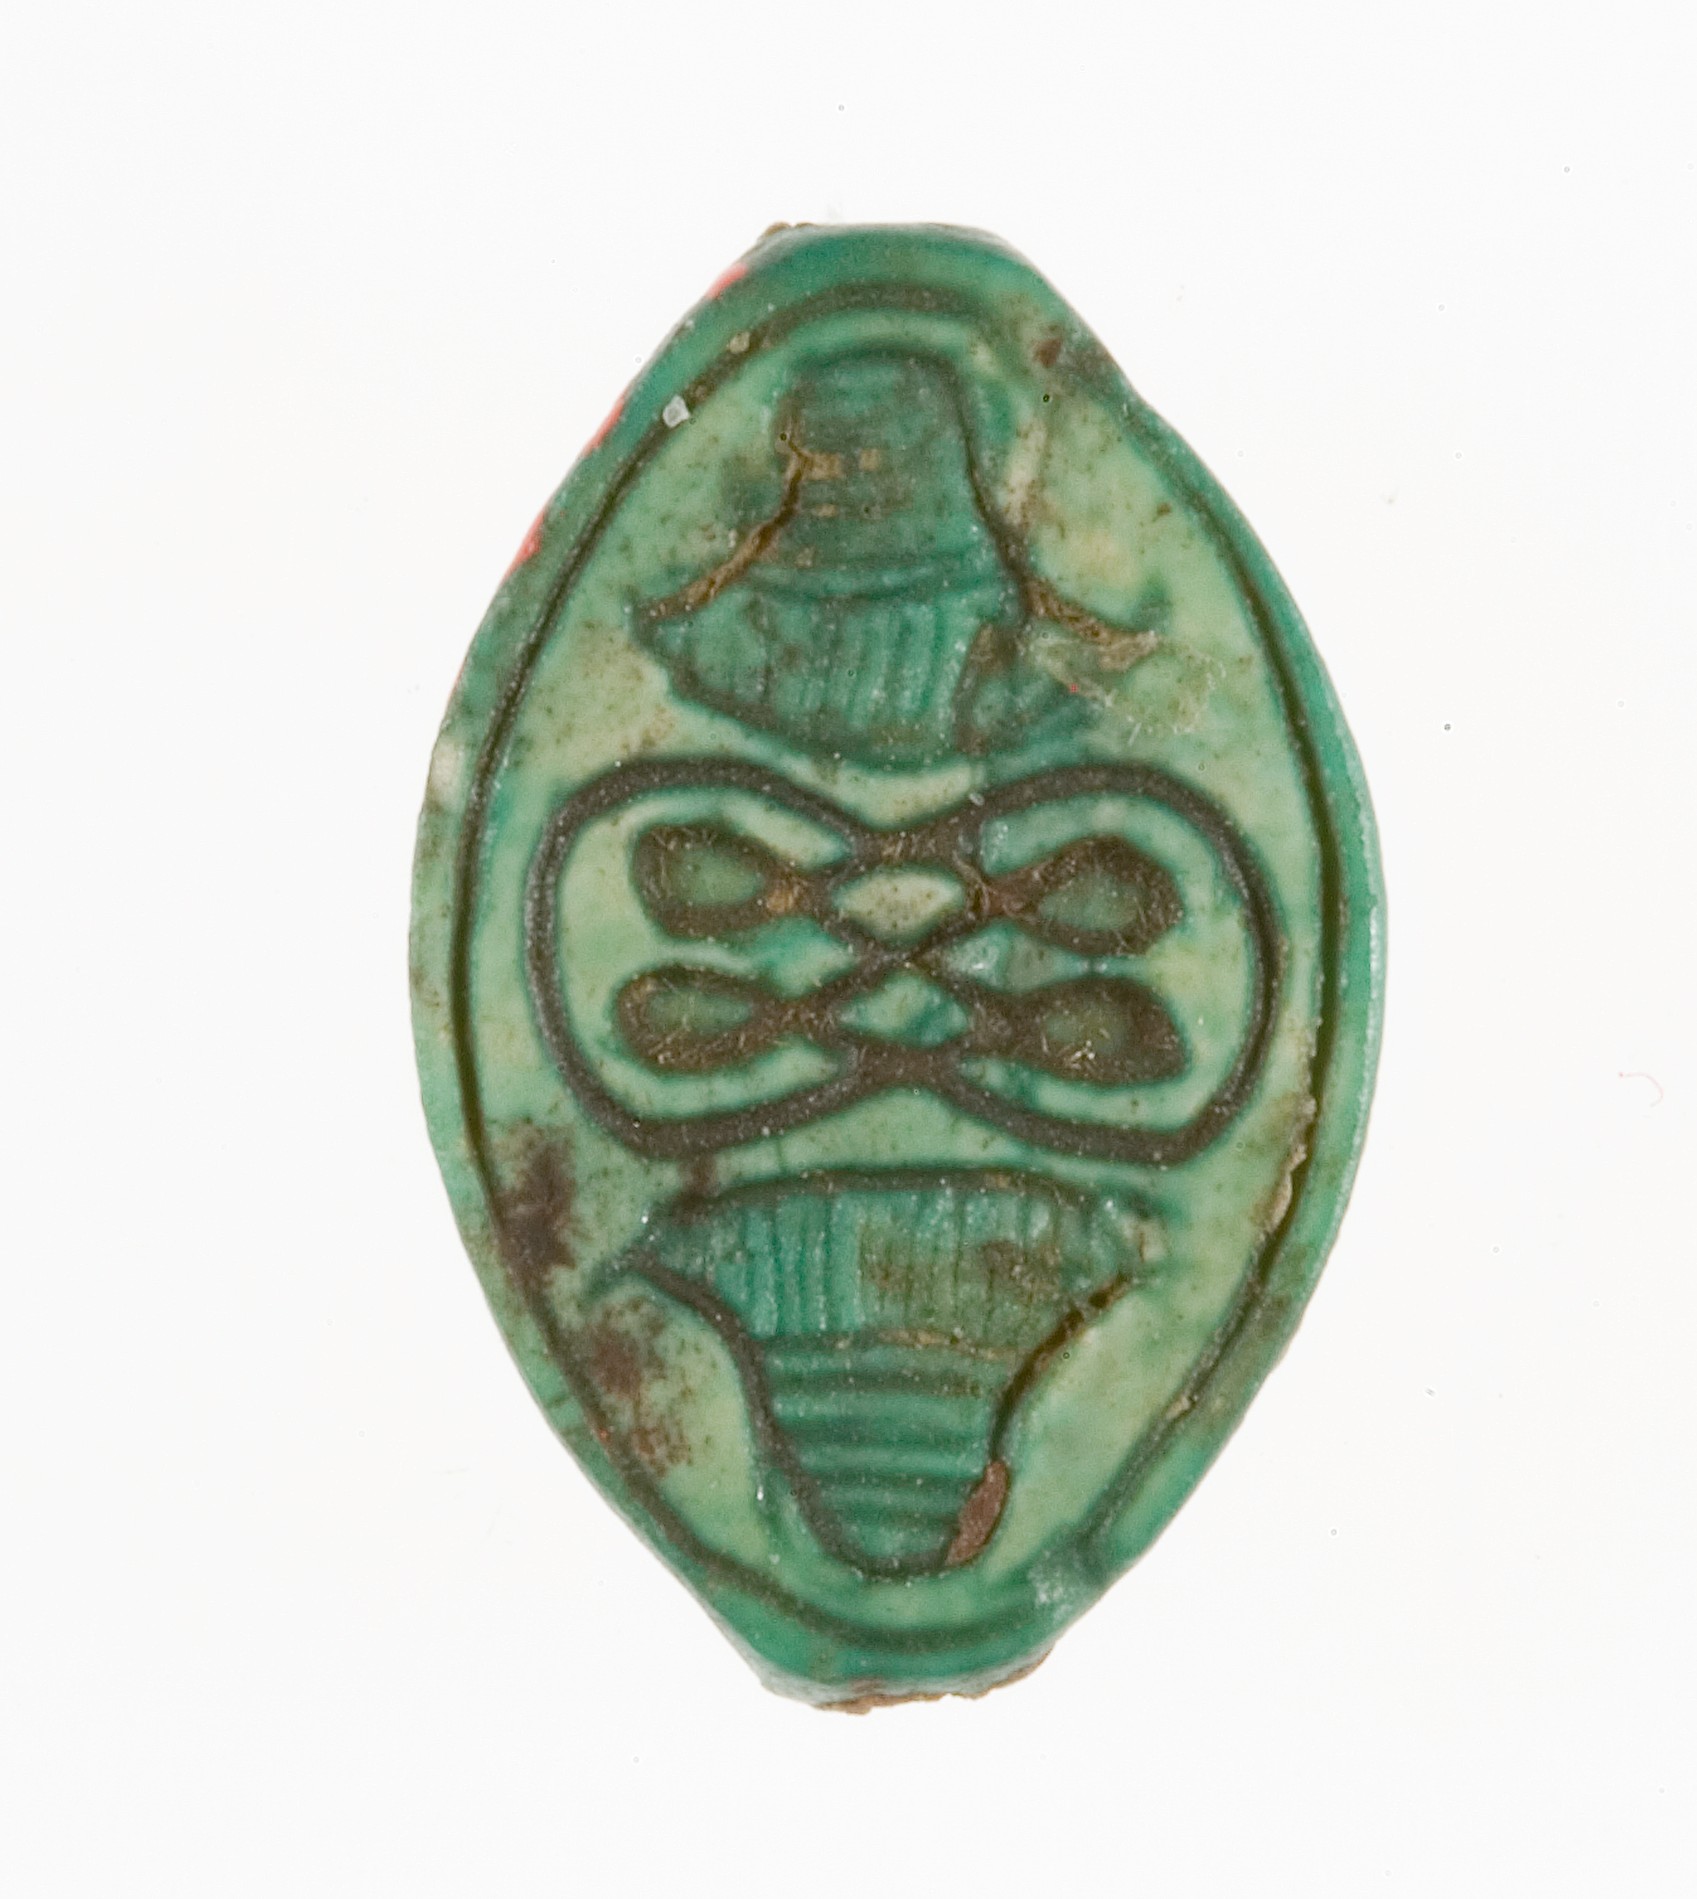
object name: cowroid, hatshepsut fd, rope, papyrus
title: Cowroid Seal Amulet Inscribed with a Geometric Pattern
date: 1479-1458 BCE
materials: stone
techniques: glazing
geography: egypt